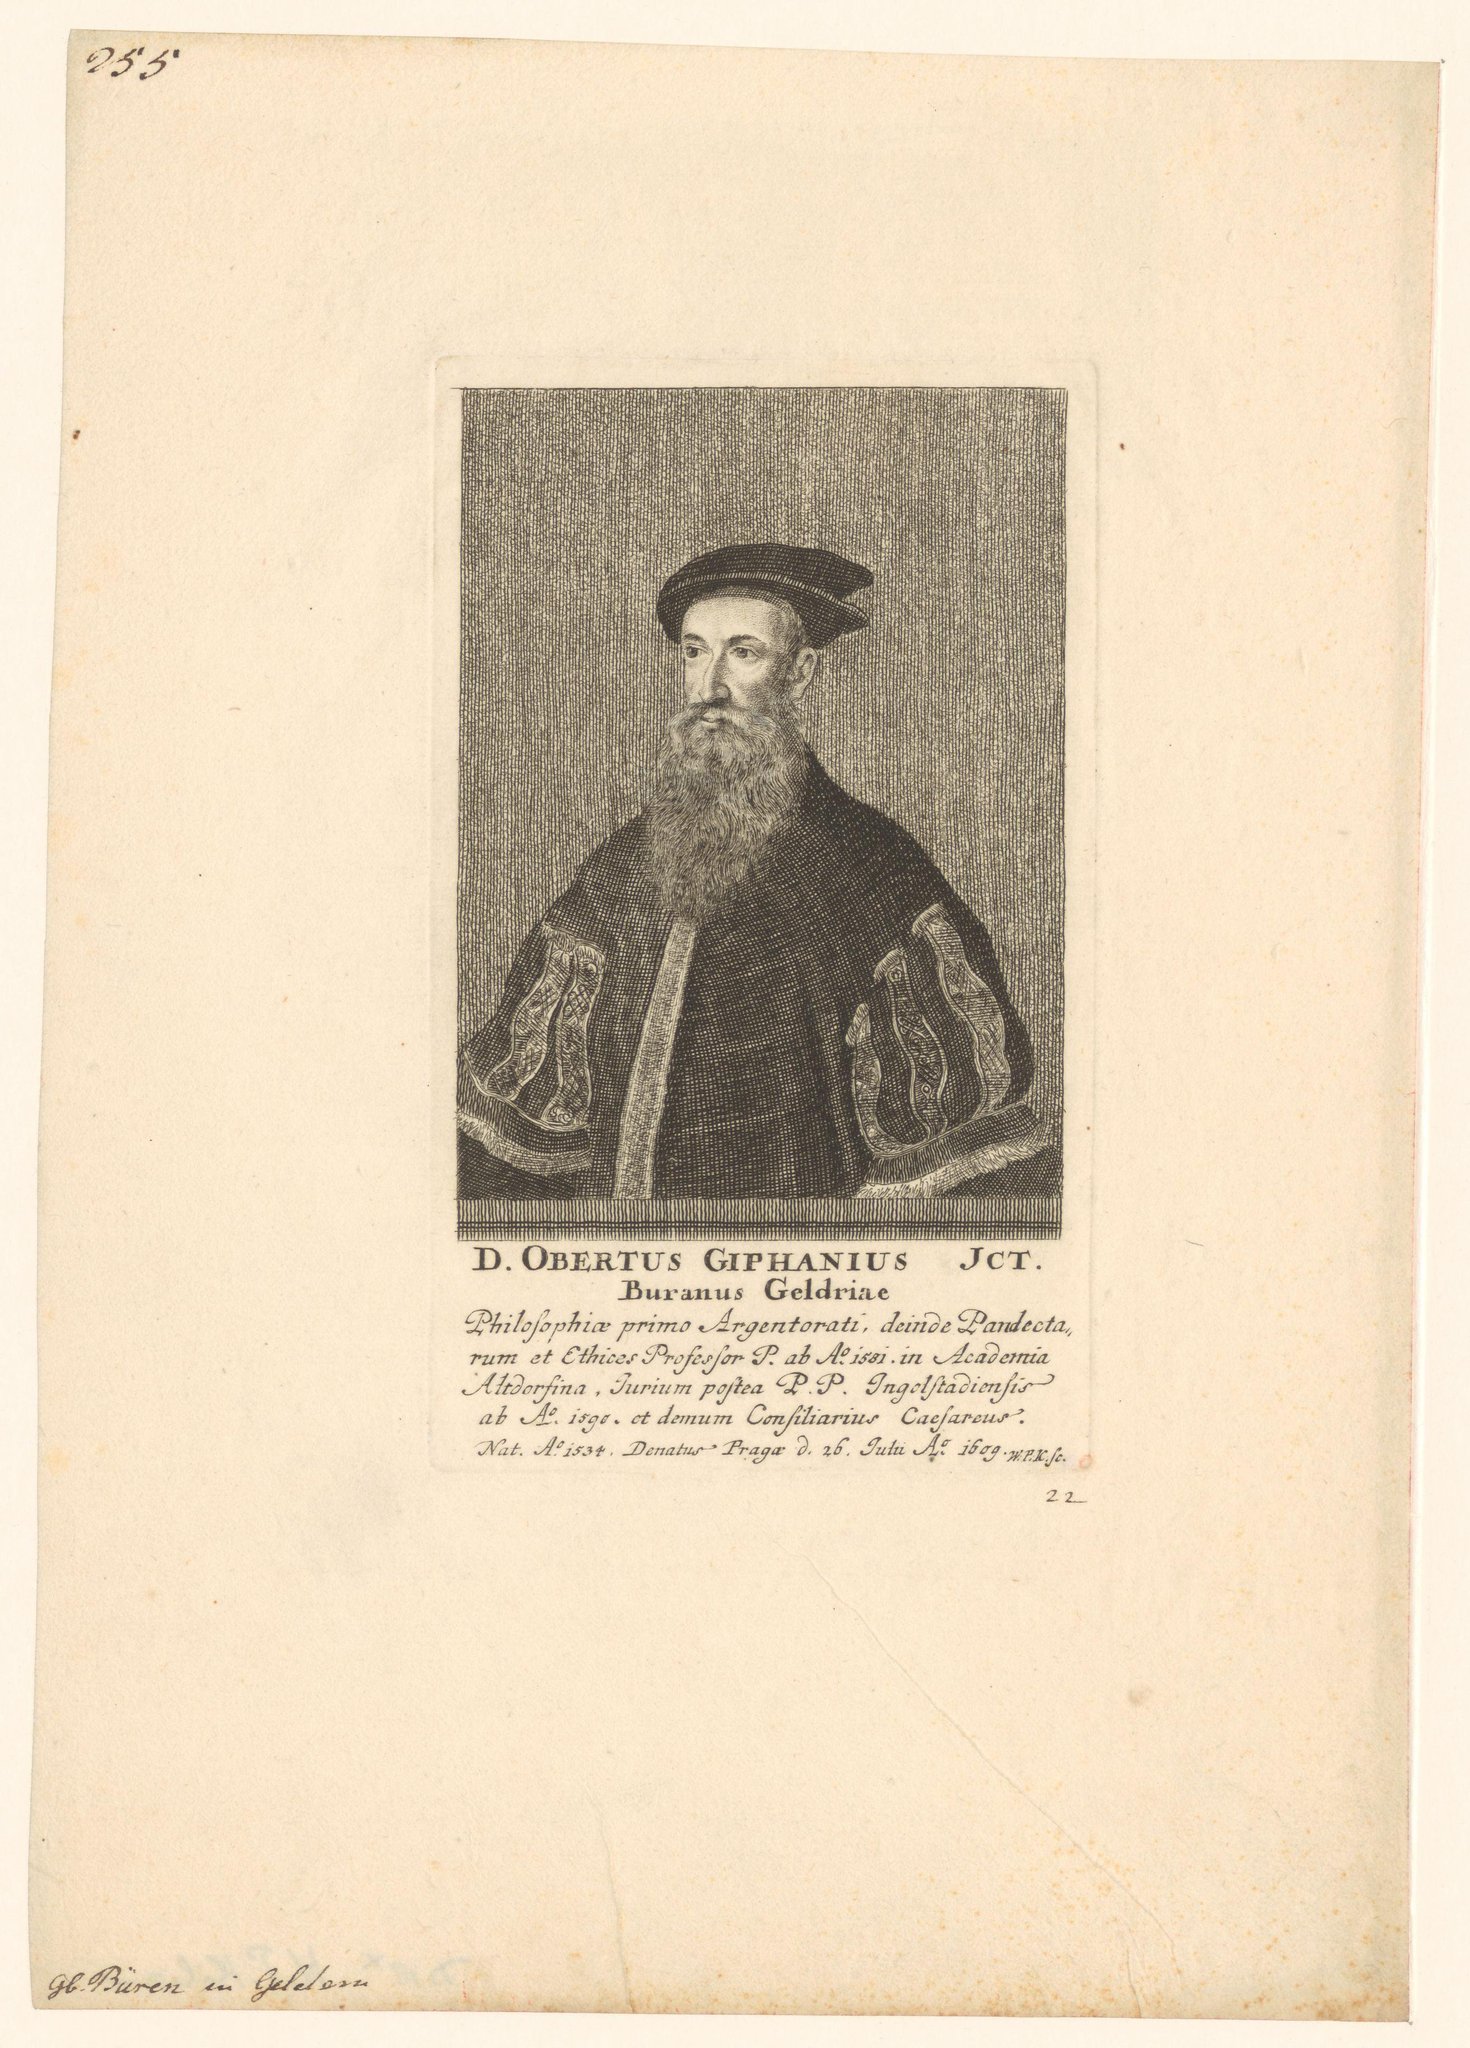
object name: print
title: Portret van Hubert van Giffen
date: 1664-1732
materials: paper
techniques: engraving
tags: buren, prague, theologian, historical persons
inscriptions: collector's mark: Lugt 2228